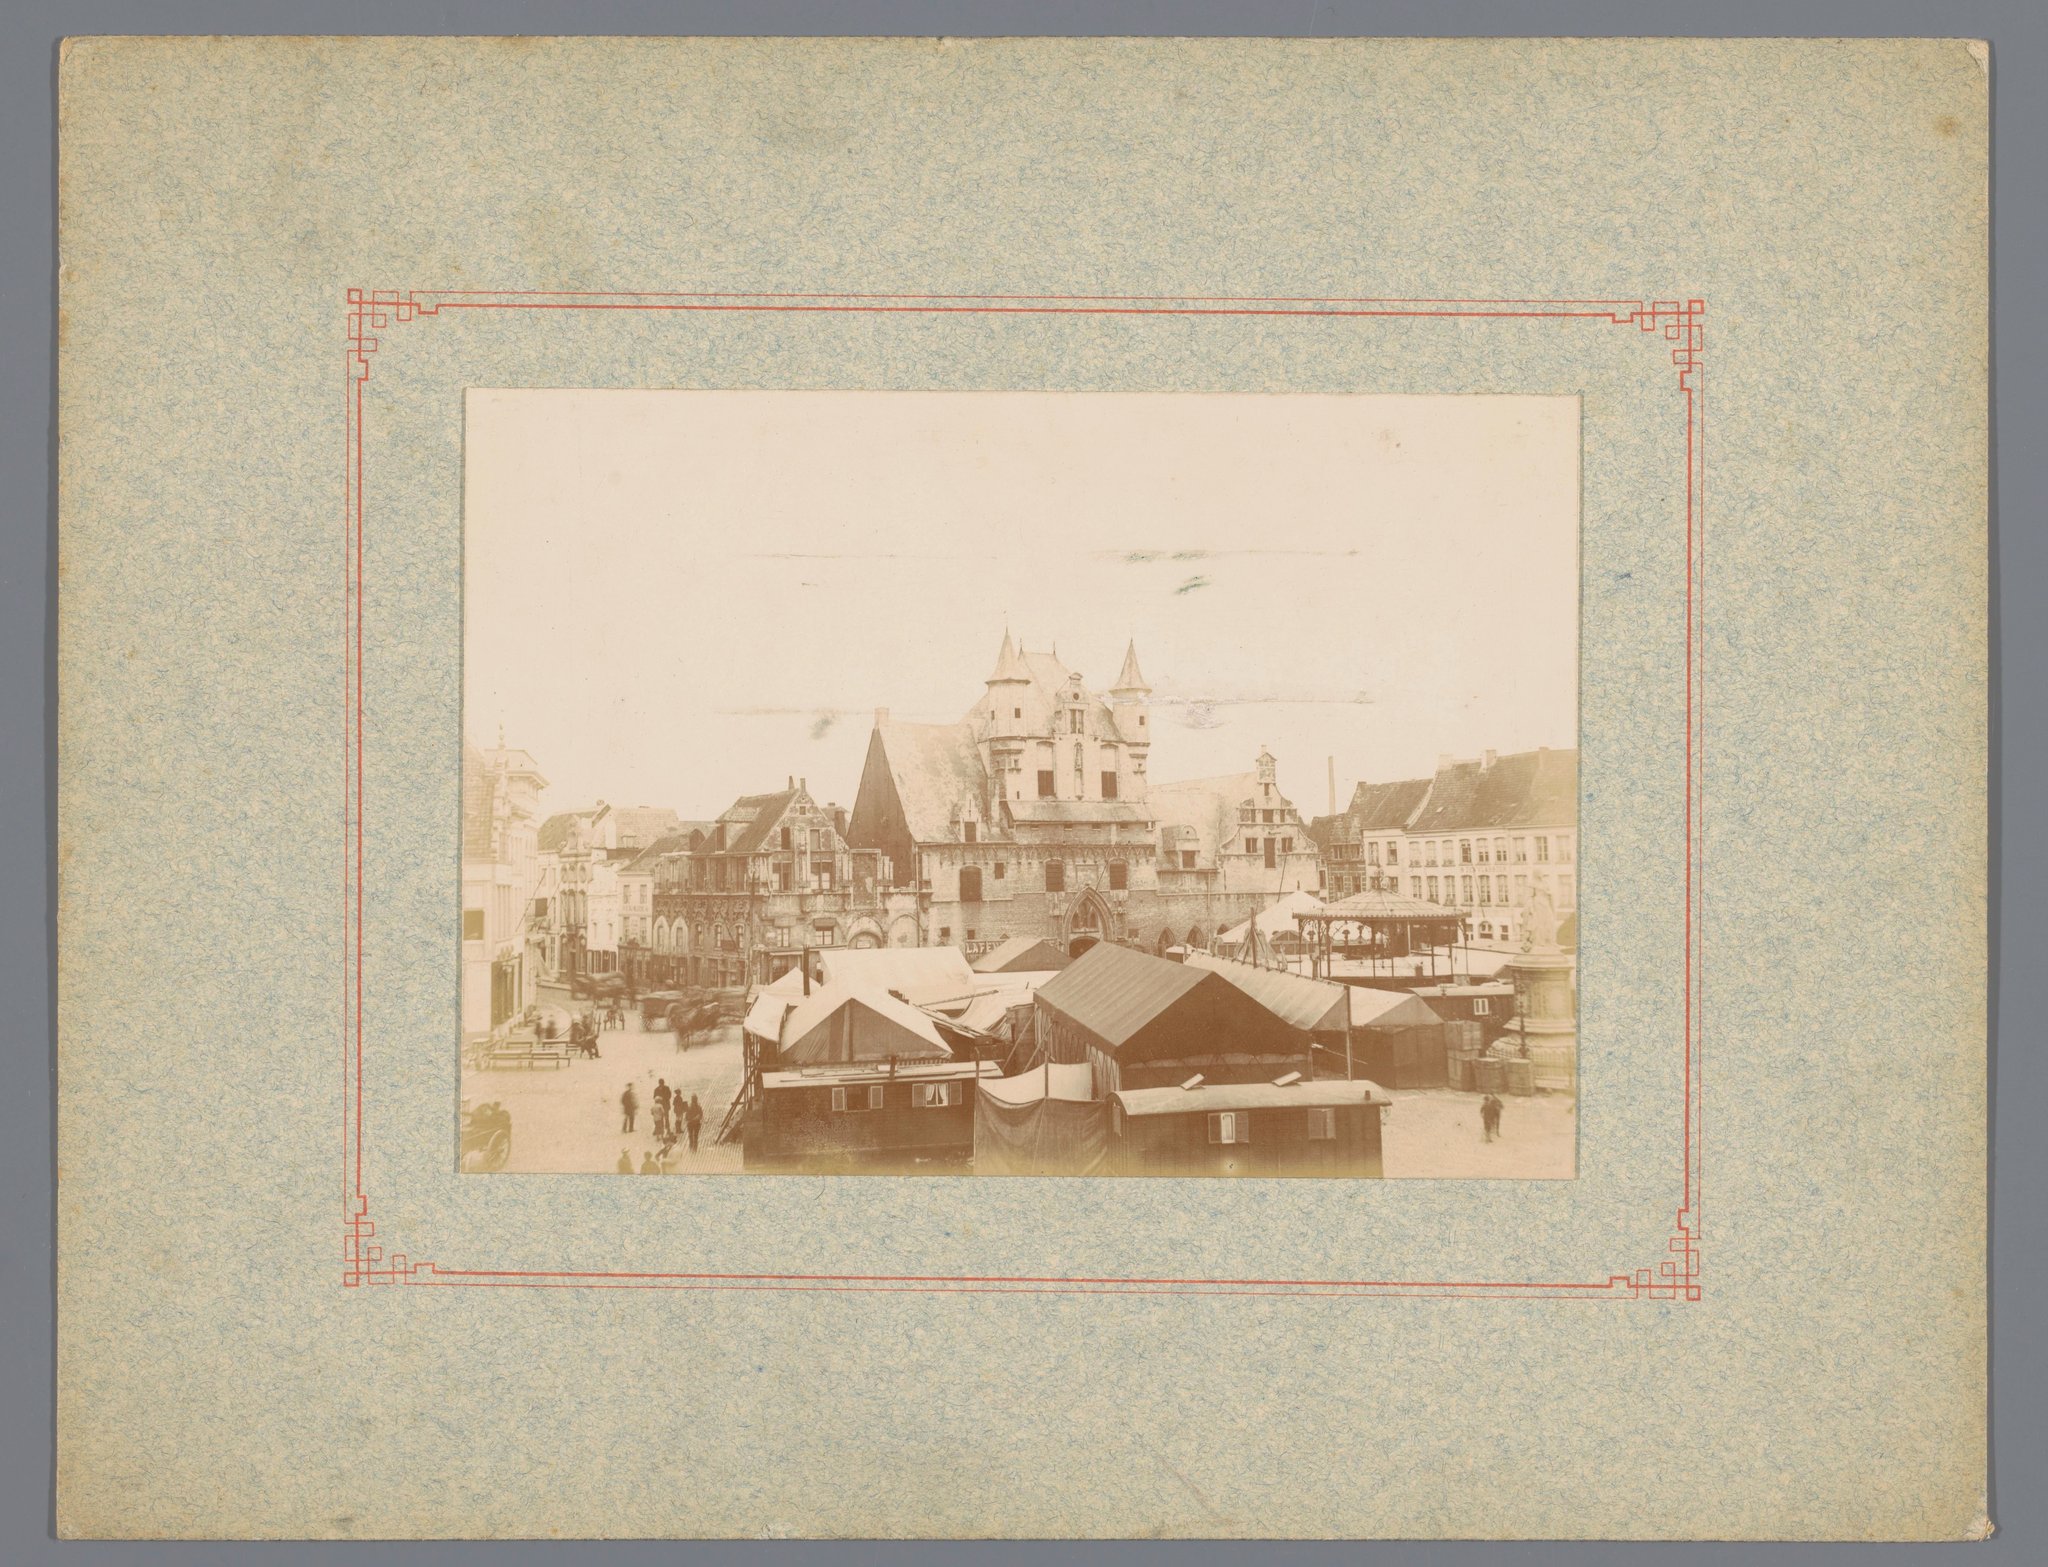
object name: photograph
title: Gezicht op de Grote Markt van Mechelen, België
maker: Anonymous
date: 1880-1900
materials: cardboard, photographic support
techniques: gelatin silver print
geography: mechelen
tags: square, place, circus, etc.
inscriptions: inscription: ‘E 31. Malines. Les Halles et Grande Place’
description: Op de achtergrond de beginselen van het paleis van de grote raad.